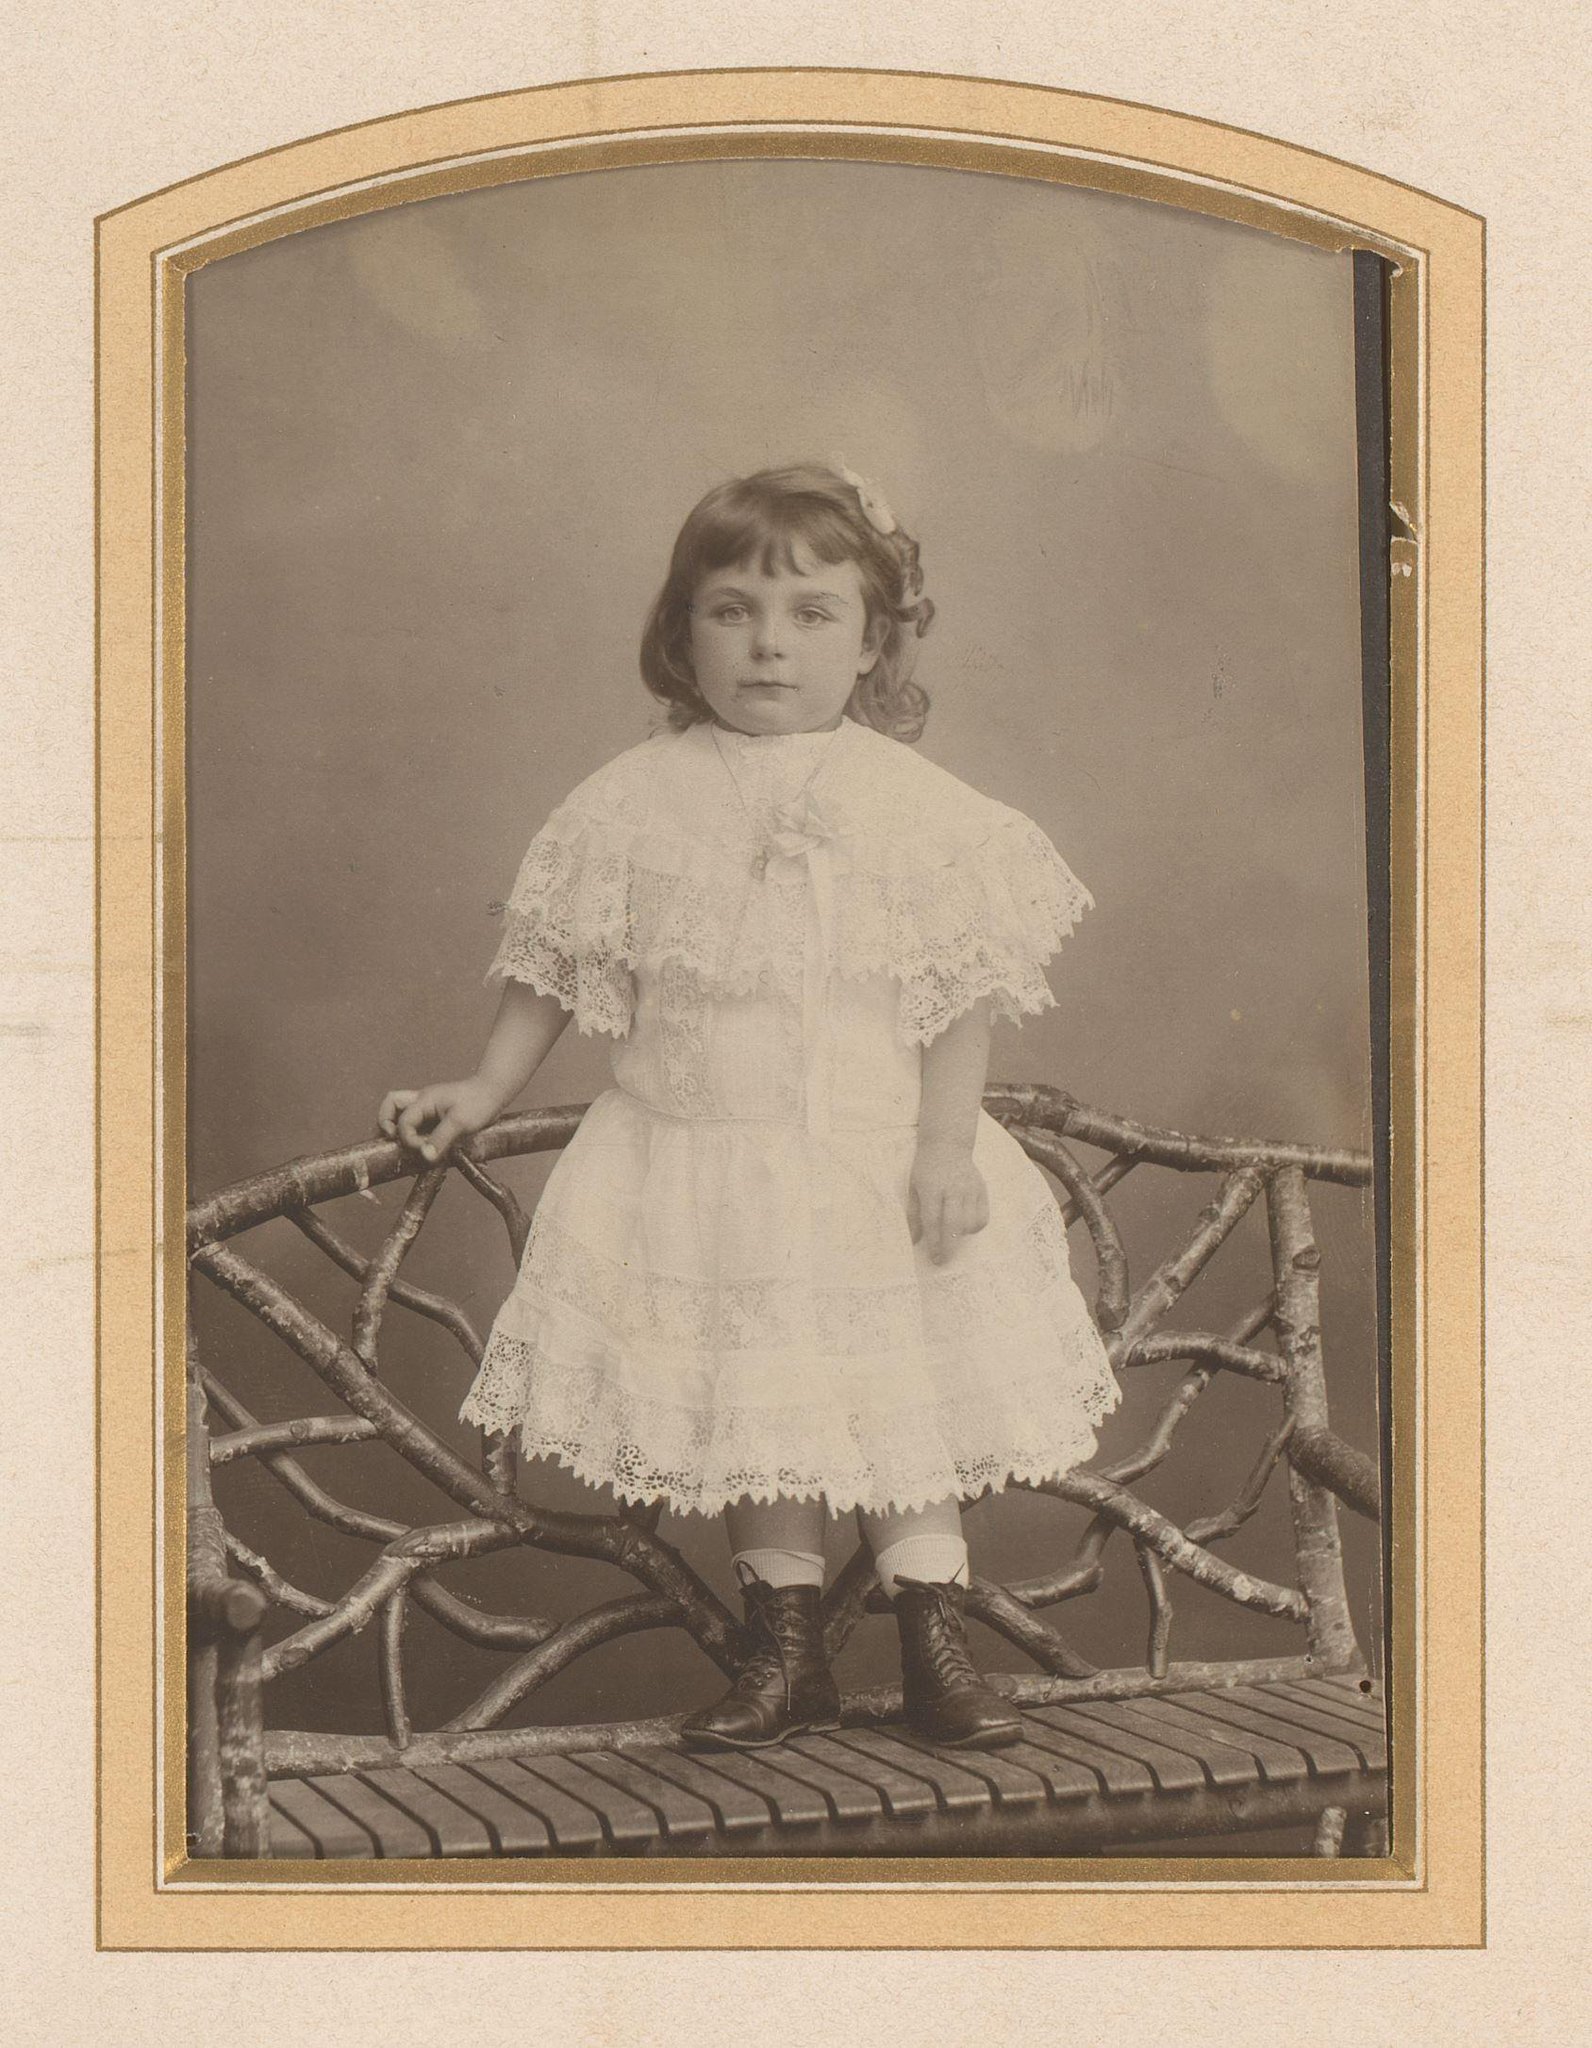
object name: photograph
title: Portret van een meisje op een houten bank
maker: a. merckling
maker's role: fotograaf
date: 1880-1920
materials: cardboard, photographic support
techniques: albumen print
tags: historical persons, girl (child between toddler and youth)